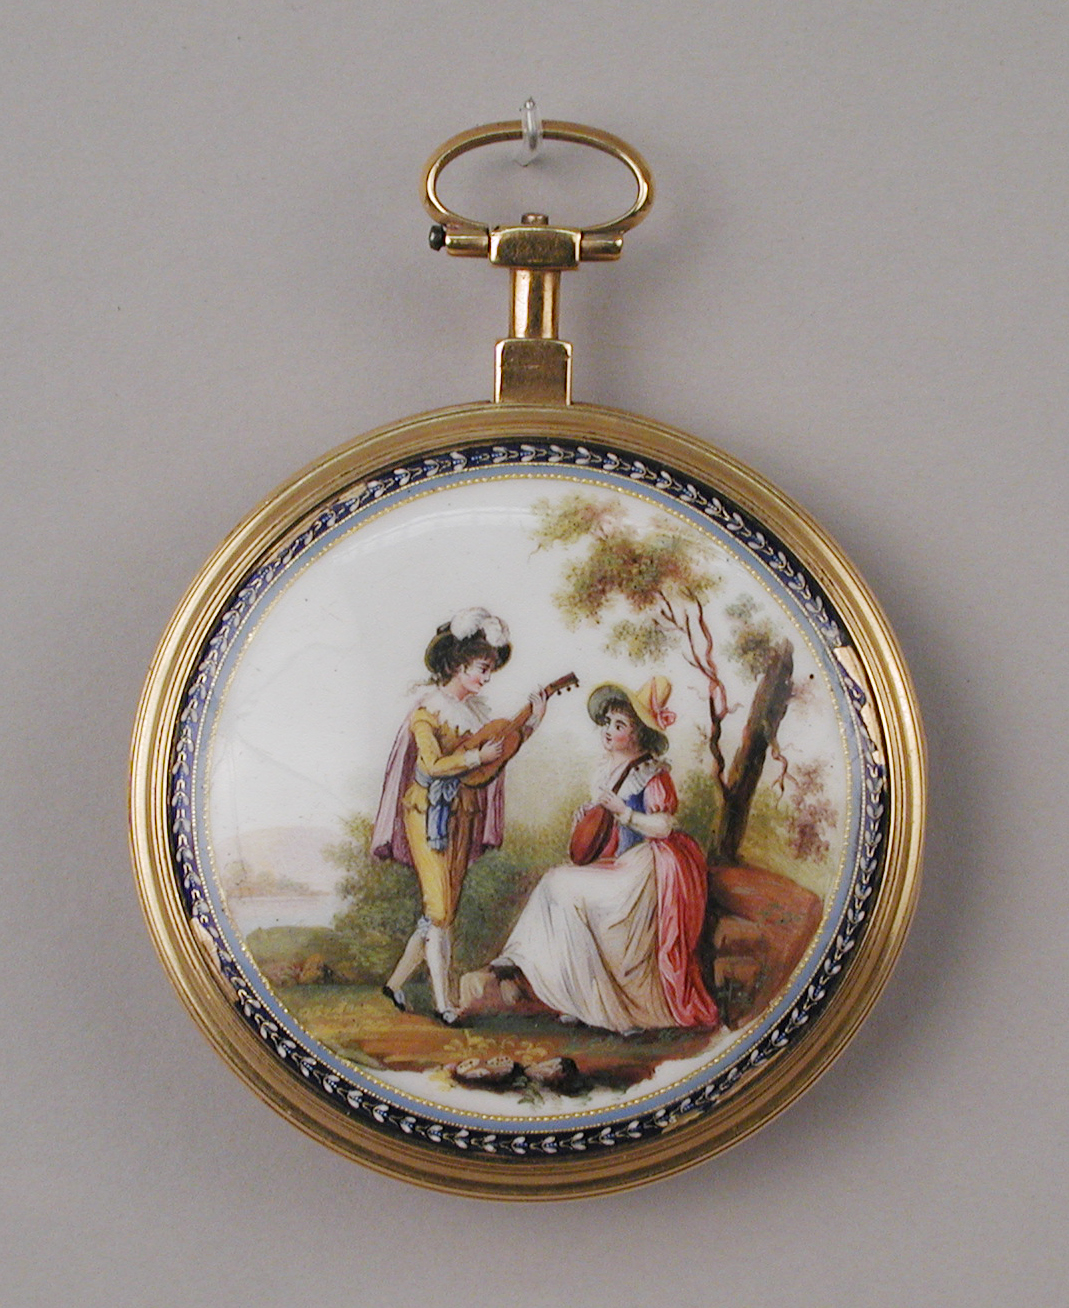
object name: watch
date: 1800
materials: enamel, gold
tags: men,women,lutes,trees